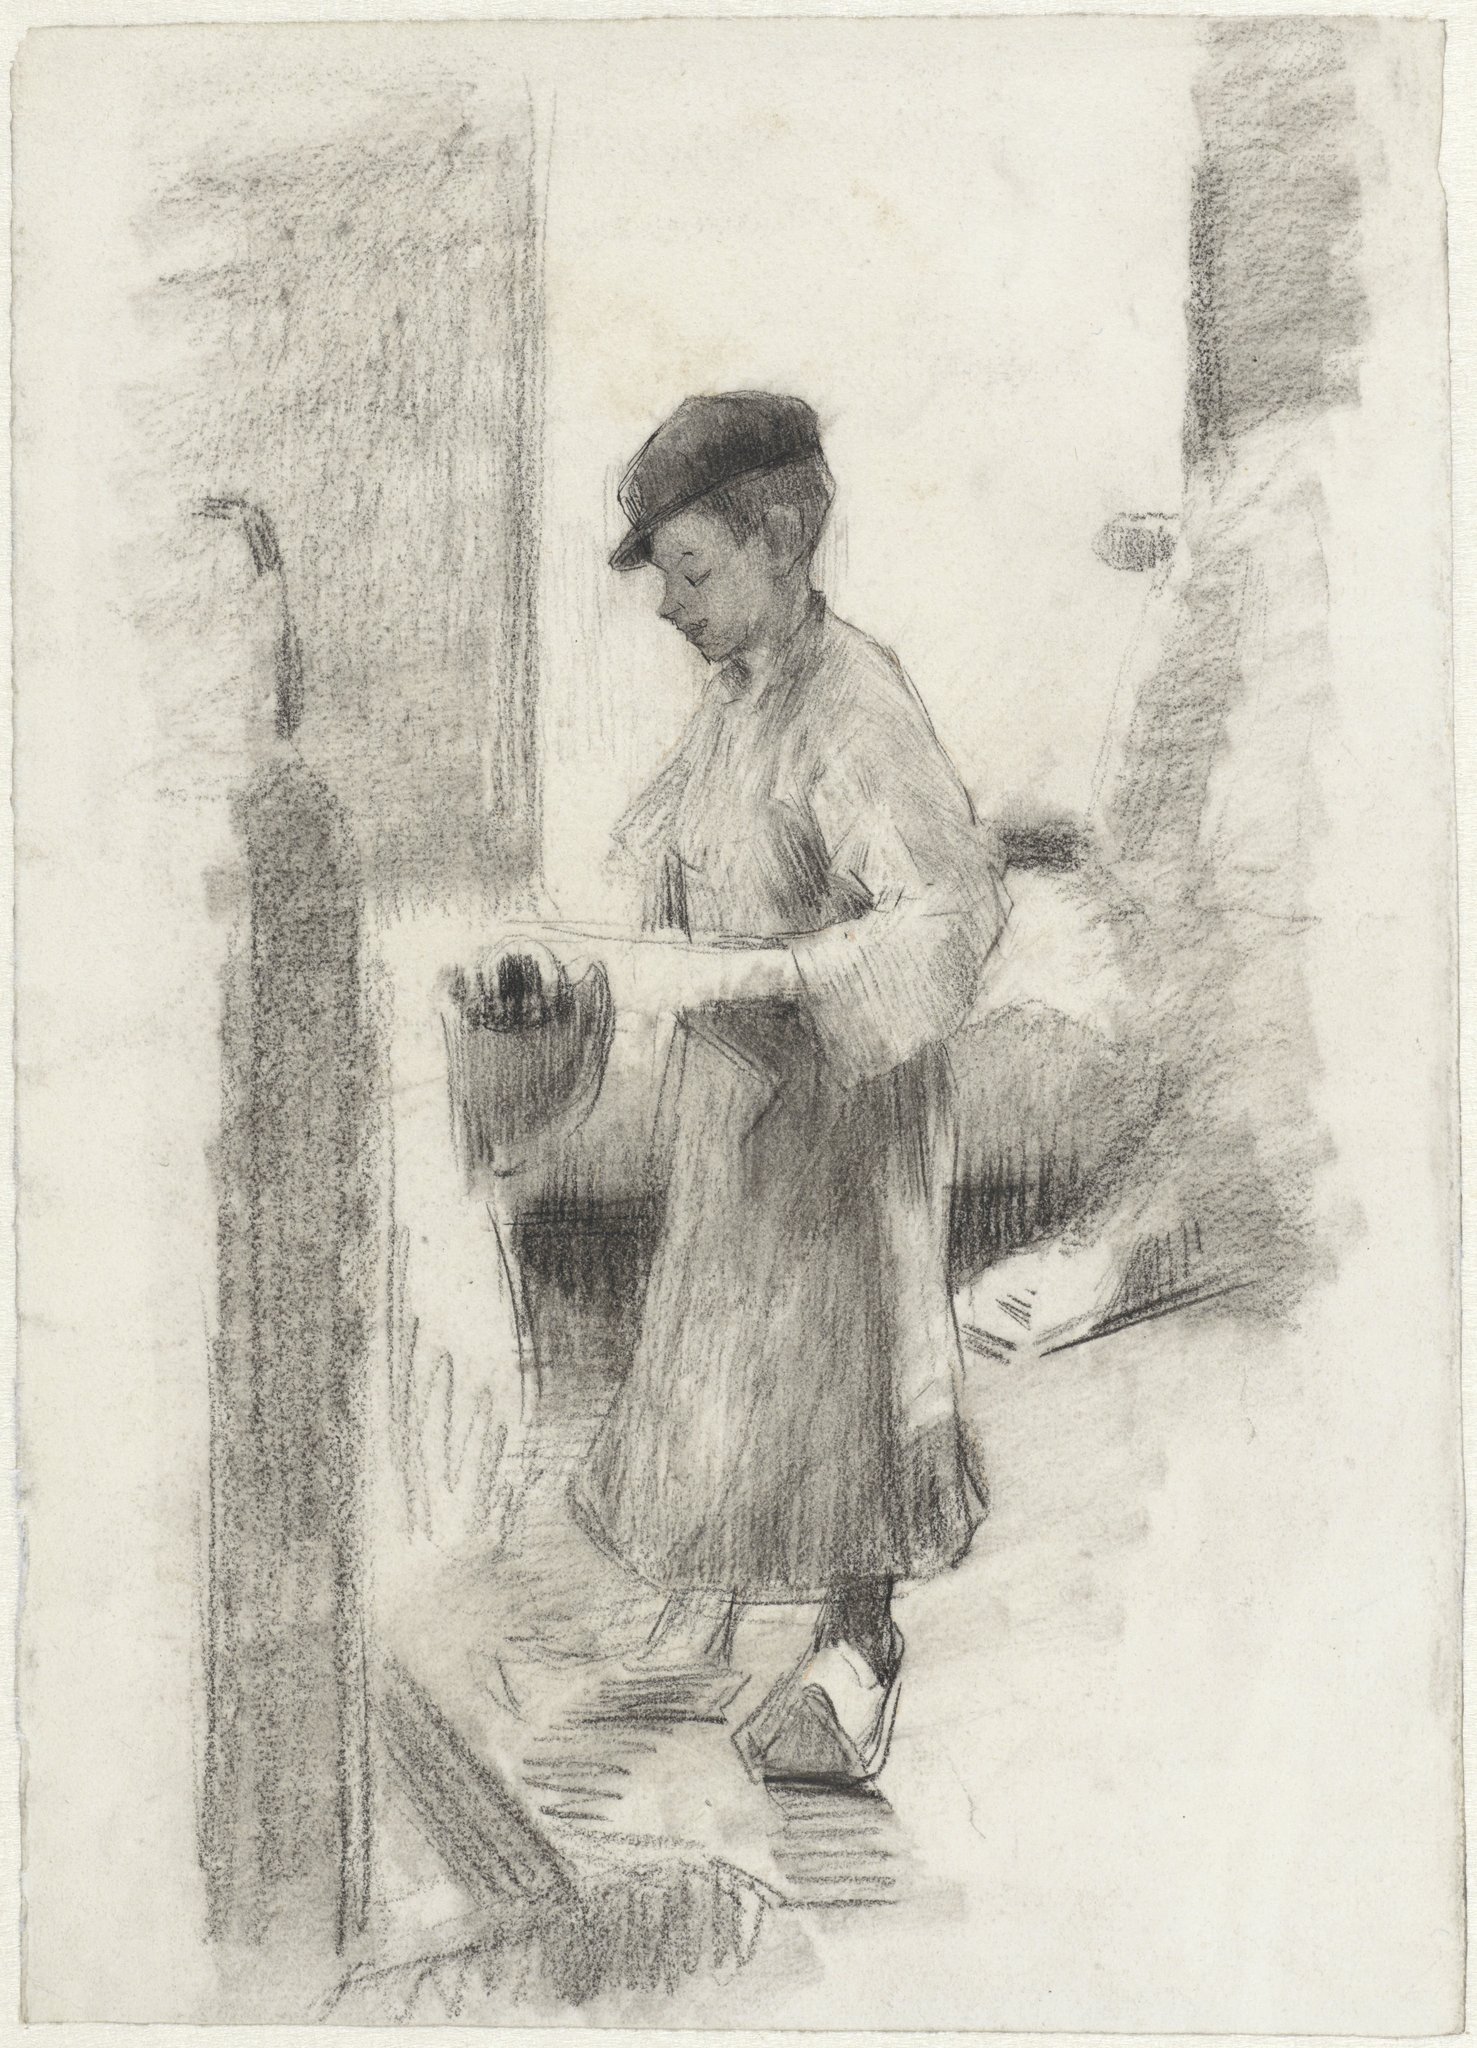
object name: drawing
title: Fabrieksjongen aan het werk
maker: anthon gerhard alexander van rappard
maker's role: draughtsman, print maker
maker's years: 1858-1892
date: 1868-1892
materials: charcoal, paper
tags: industries (+ children (labourers)), child labour